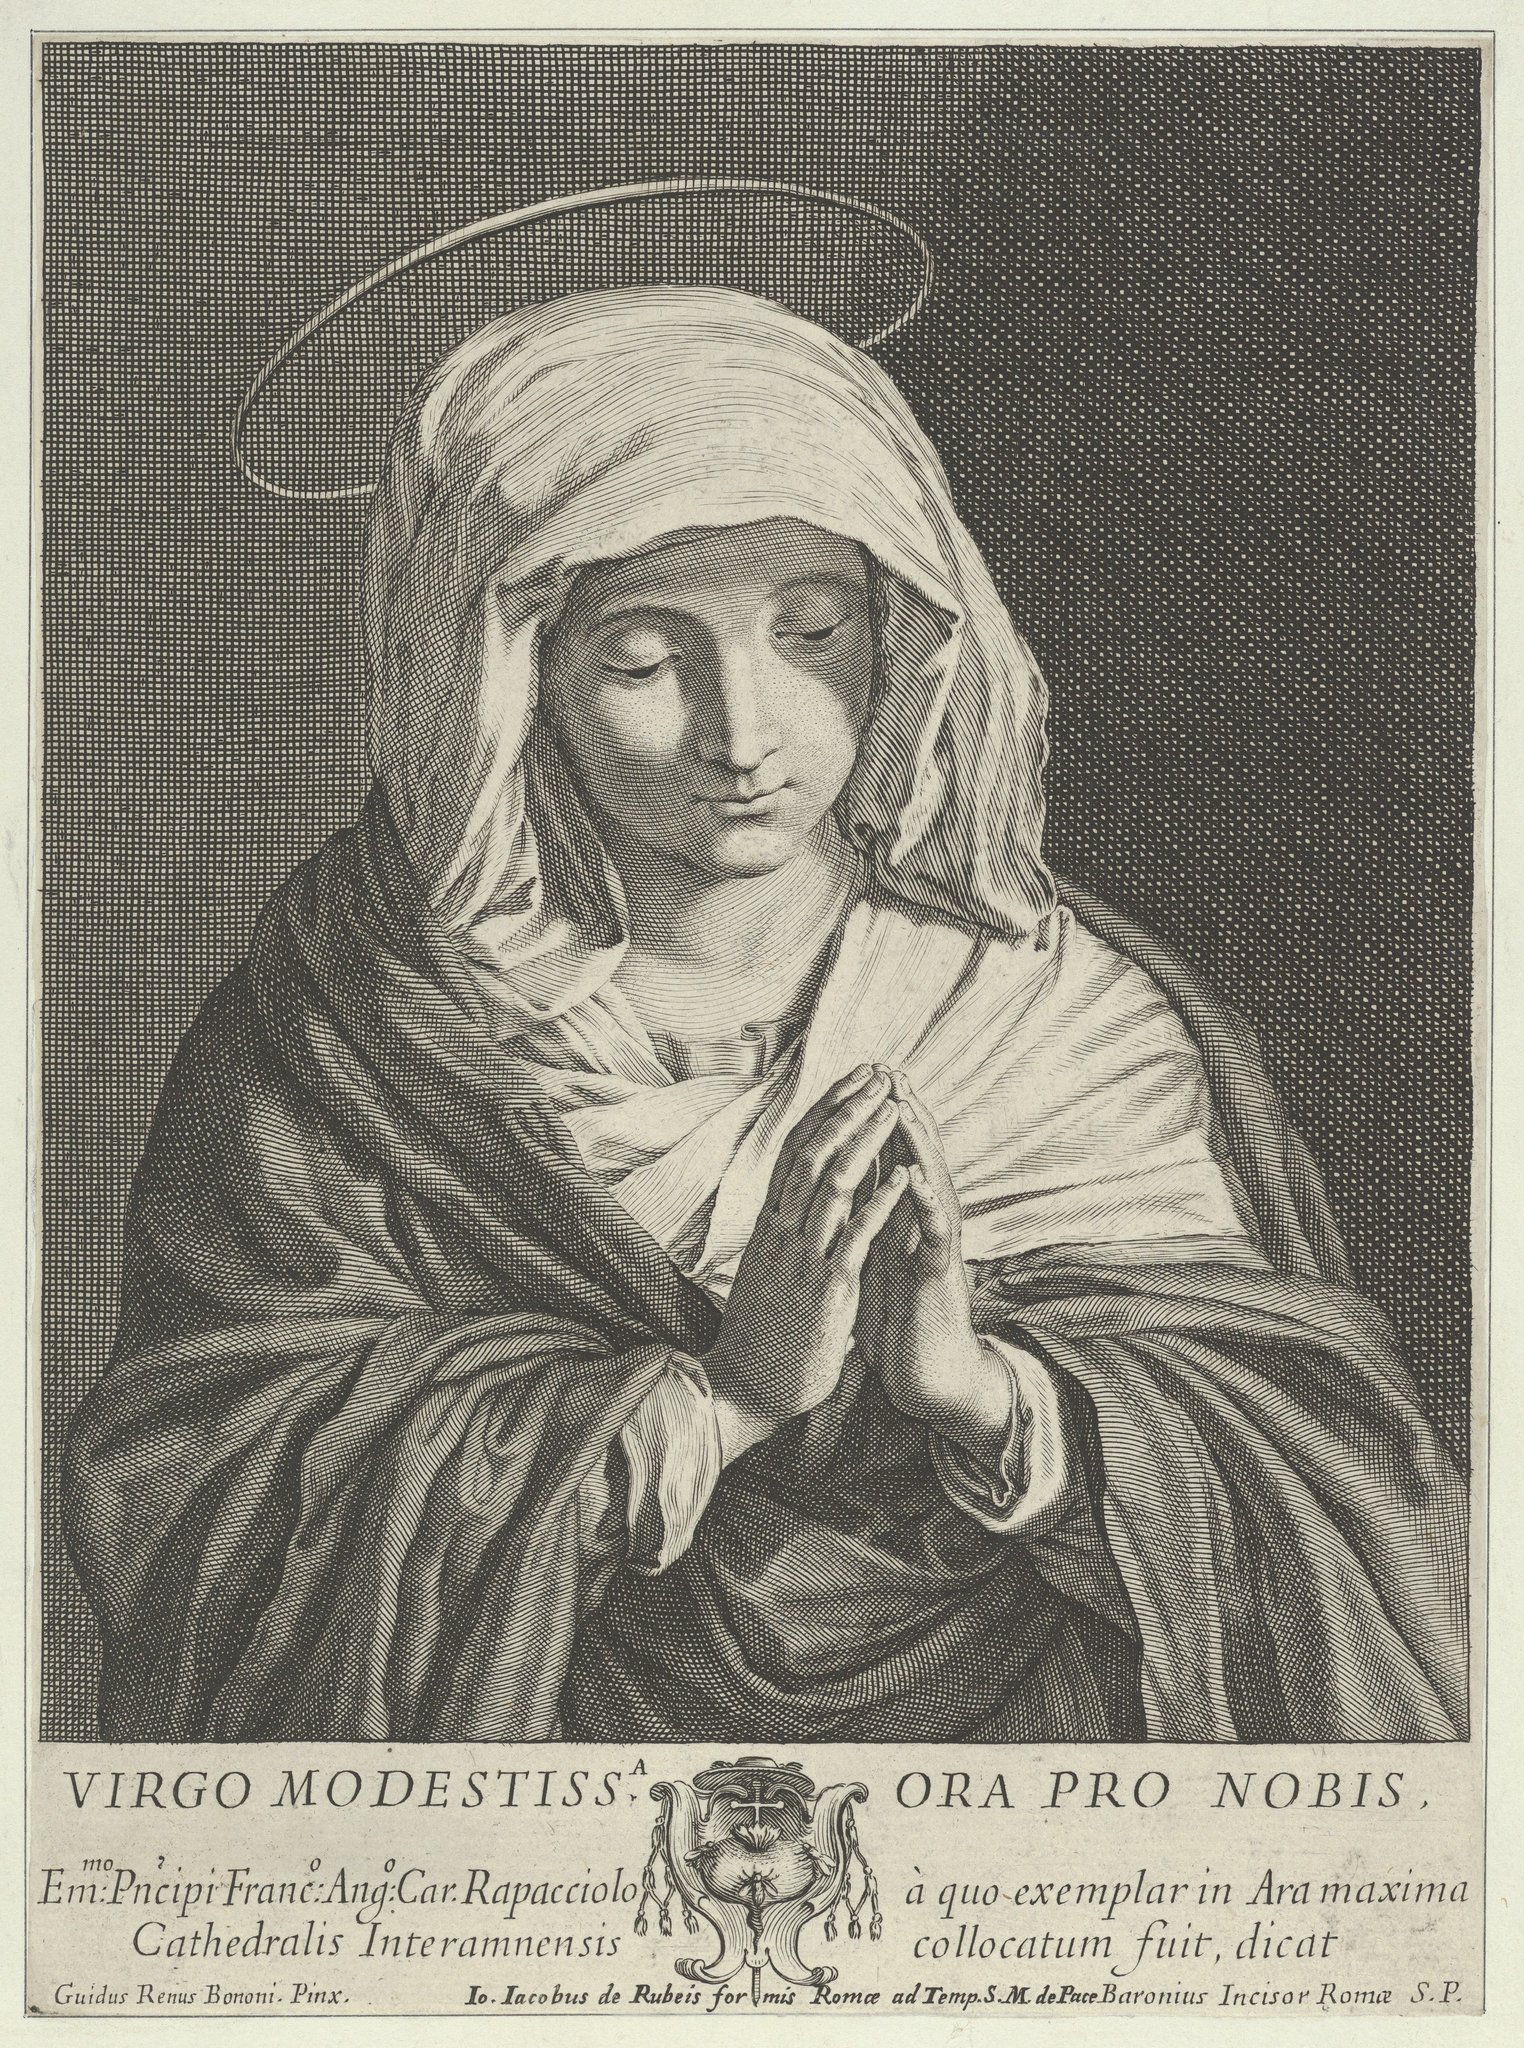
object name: print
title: The Virgin in prayer looking down, after Reni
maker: jean baron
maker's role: artist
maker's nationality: french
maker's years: 1616-1660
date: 1650-1660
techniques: engraving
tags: virgin mary